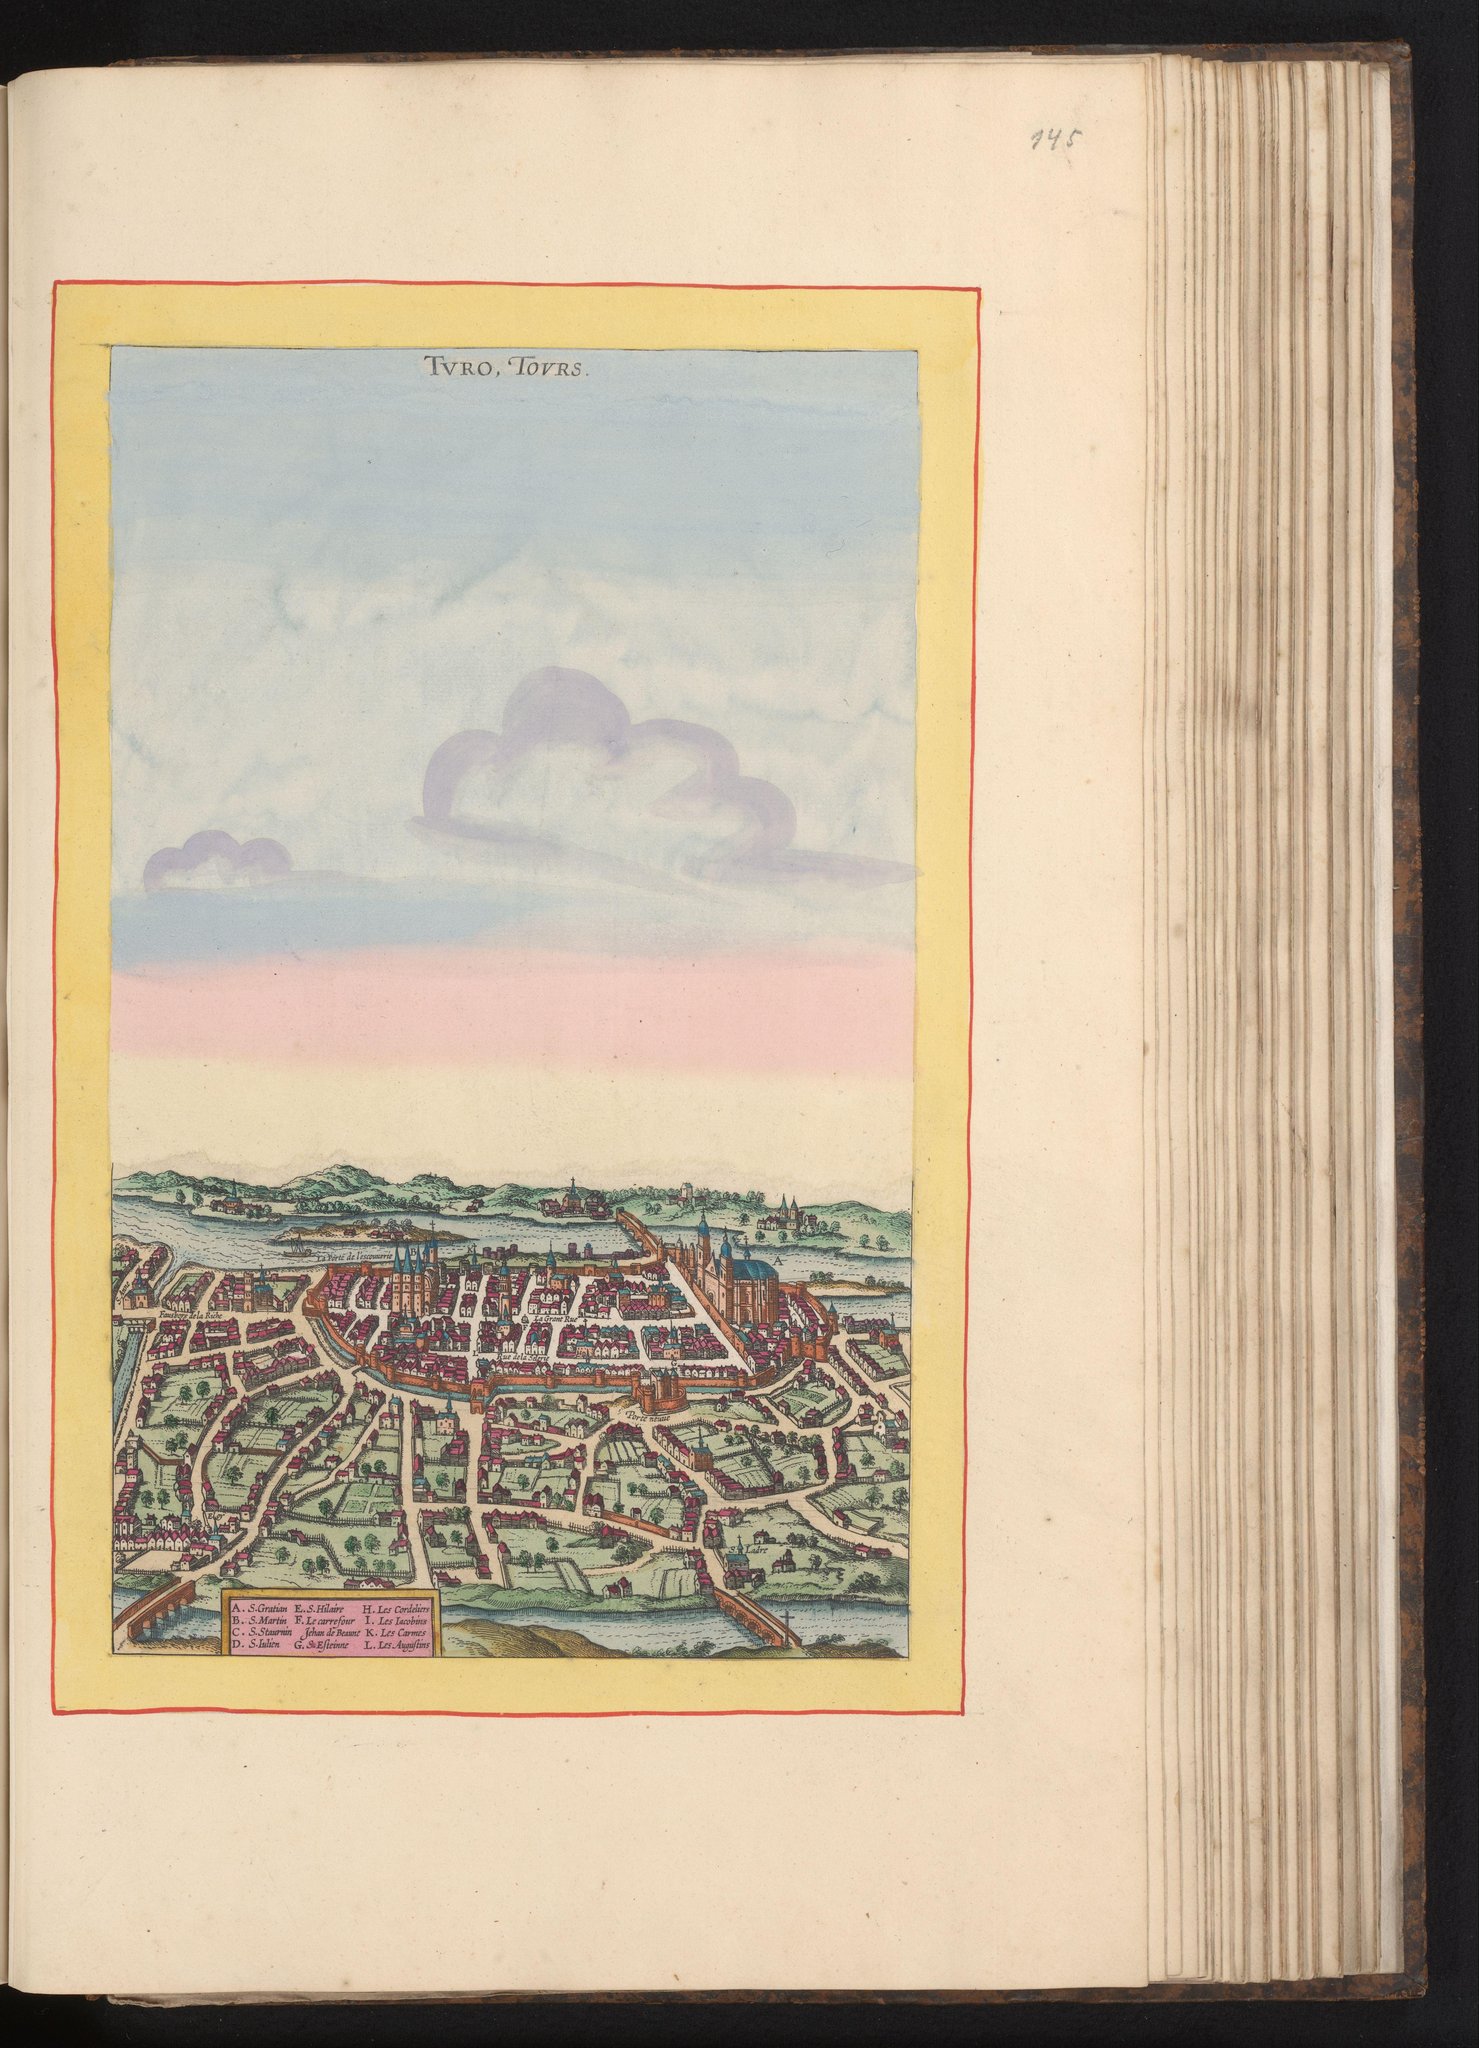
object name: print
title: Gezicht op Tours in vogelvluchtperspectief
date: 1610-1657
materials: paper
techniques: engraving, etching, hand coloring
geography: amsterdam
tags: city-view in general; 'veduta'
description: Origineel gedrukt op één blad met een gezicht op Montpellier (RP-P-1956-306) en Poitiers (RP-P-1956-217). Deze prent is in een aantal atlassen gebruikt. Onder andere in: Braun, Georg & Franz Hogenberg. Civitates orbis terrarum. S.l.s.n., ca. 1610 (en in de editie van 1612), evenals in: Theatrum exhibens celebriores Galliae et Helvetae urbes. Amsterdam: Johannes Janssonius, 1657.